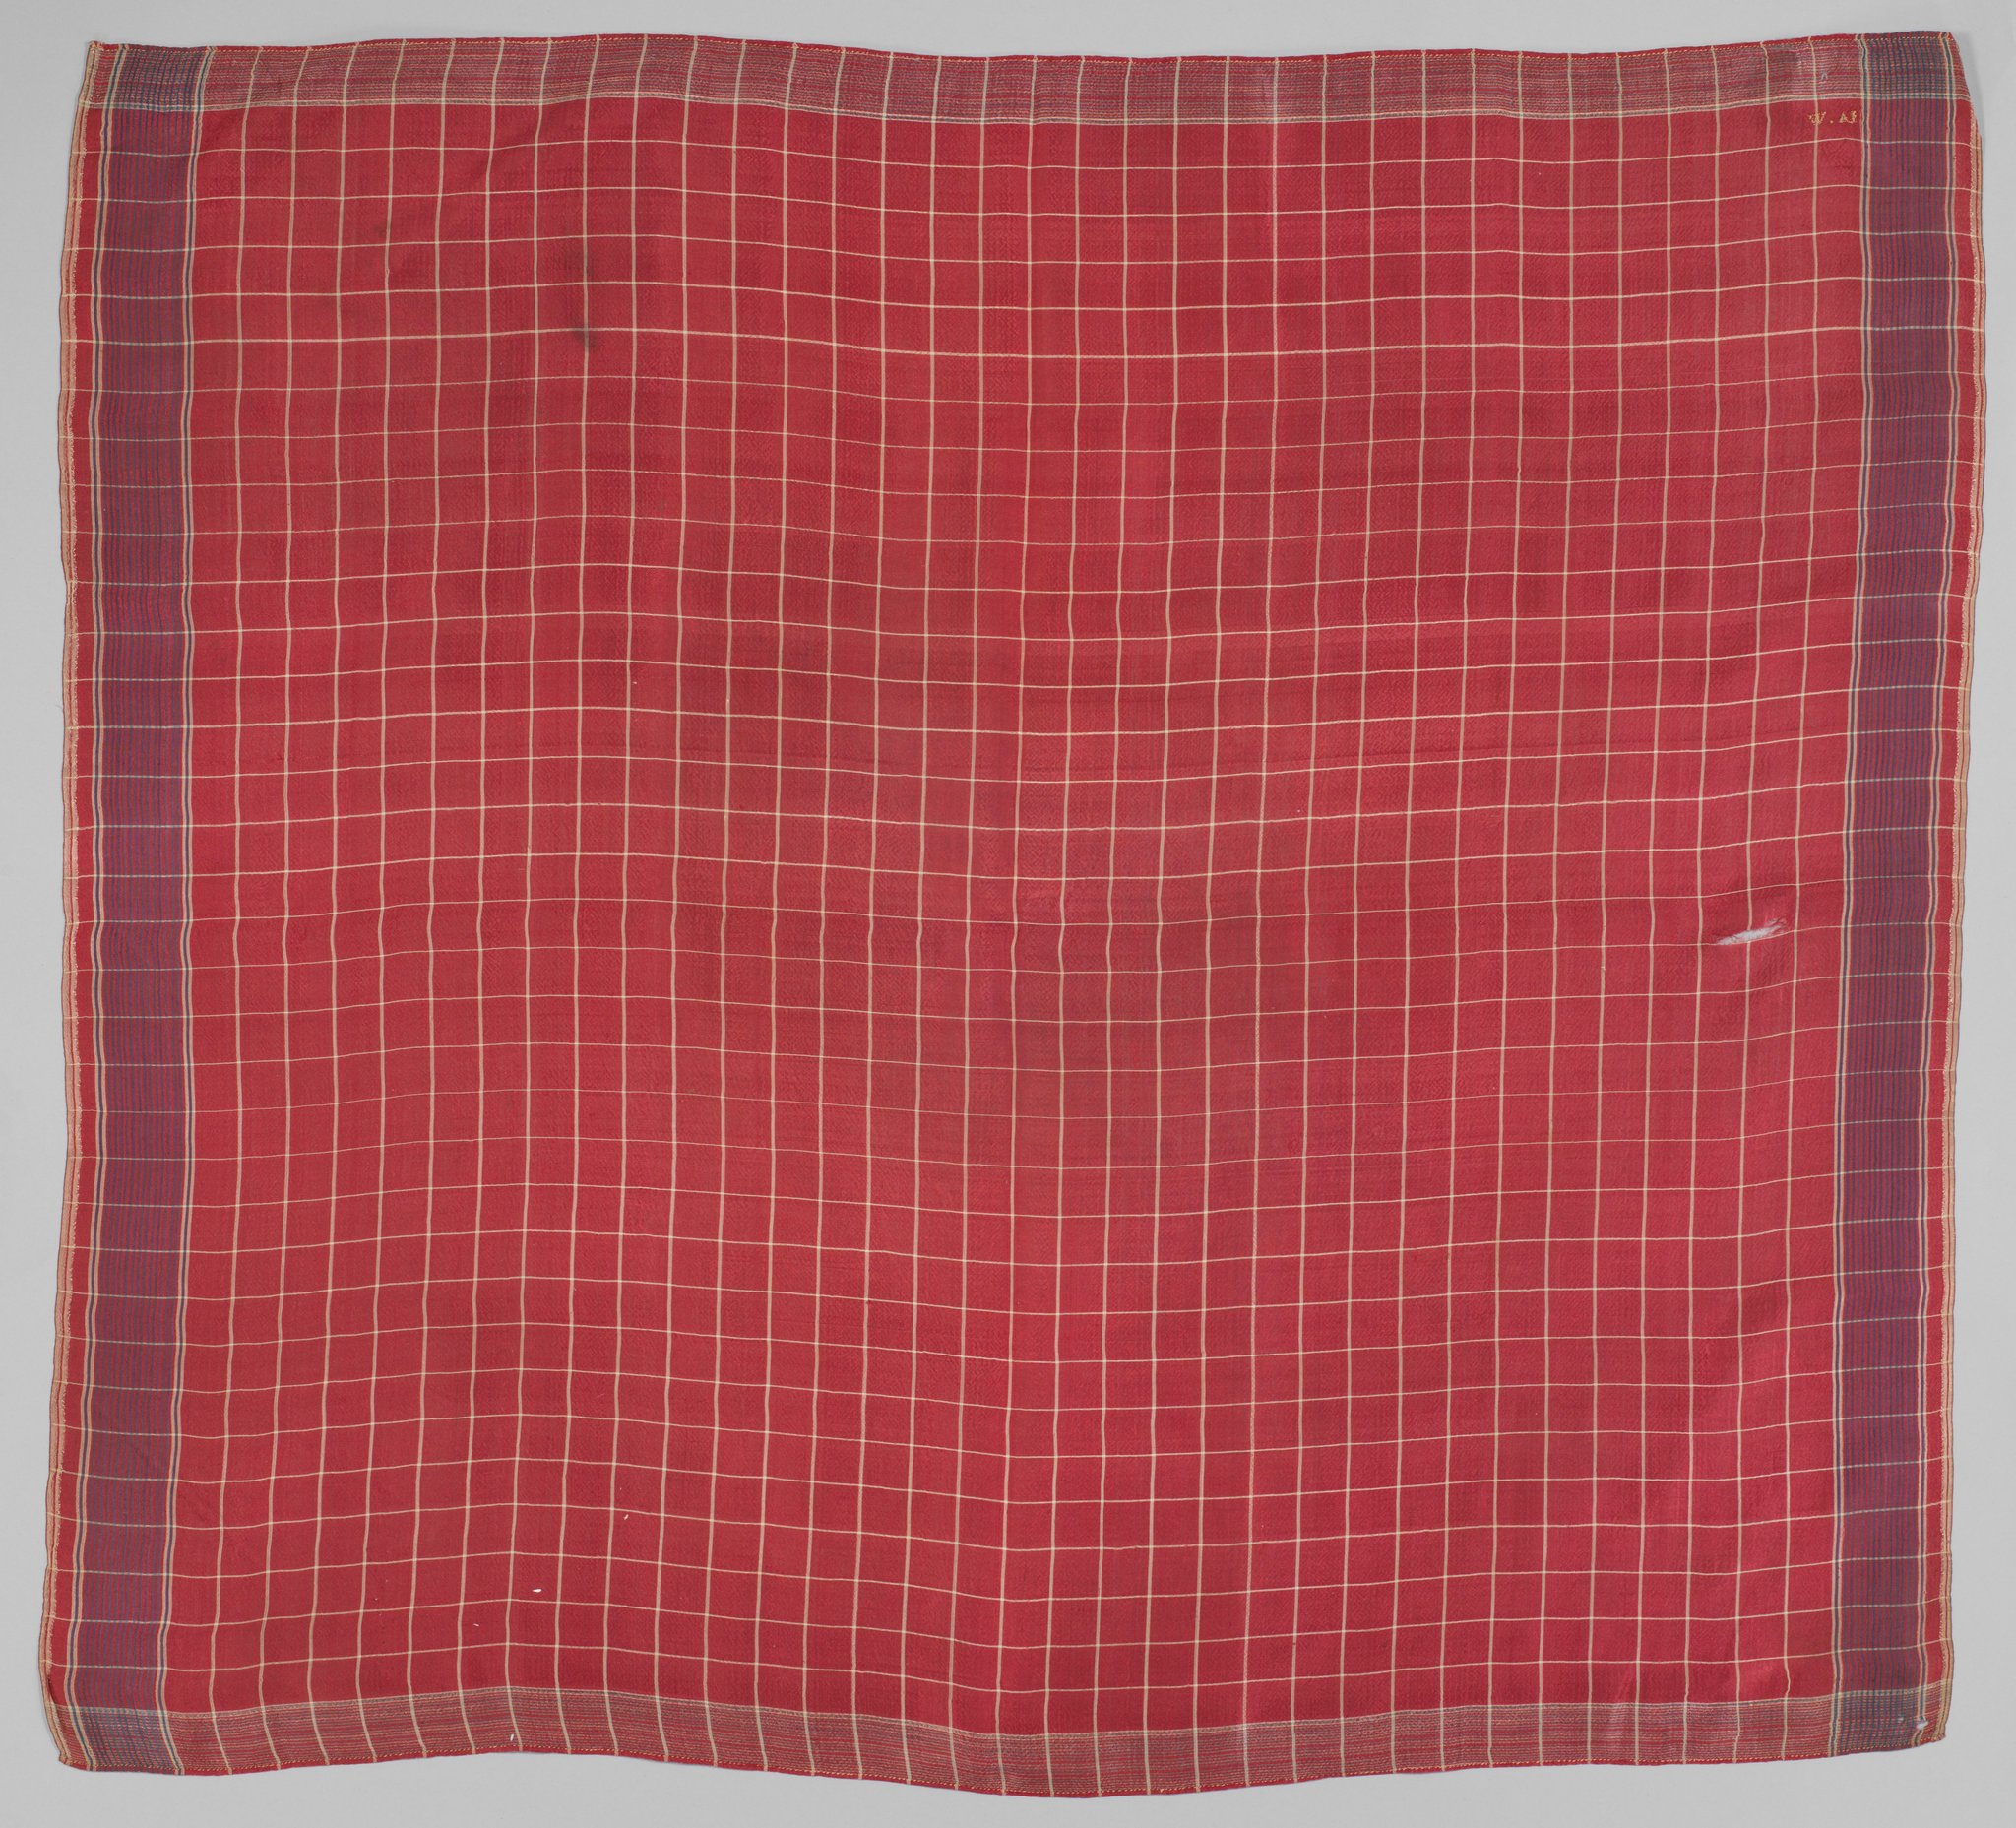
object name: handkerchief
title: Man's handkerchief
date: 1801-1900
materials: silk